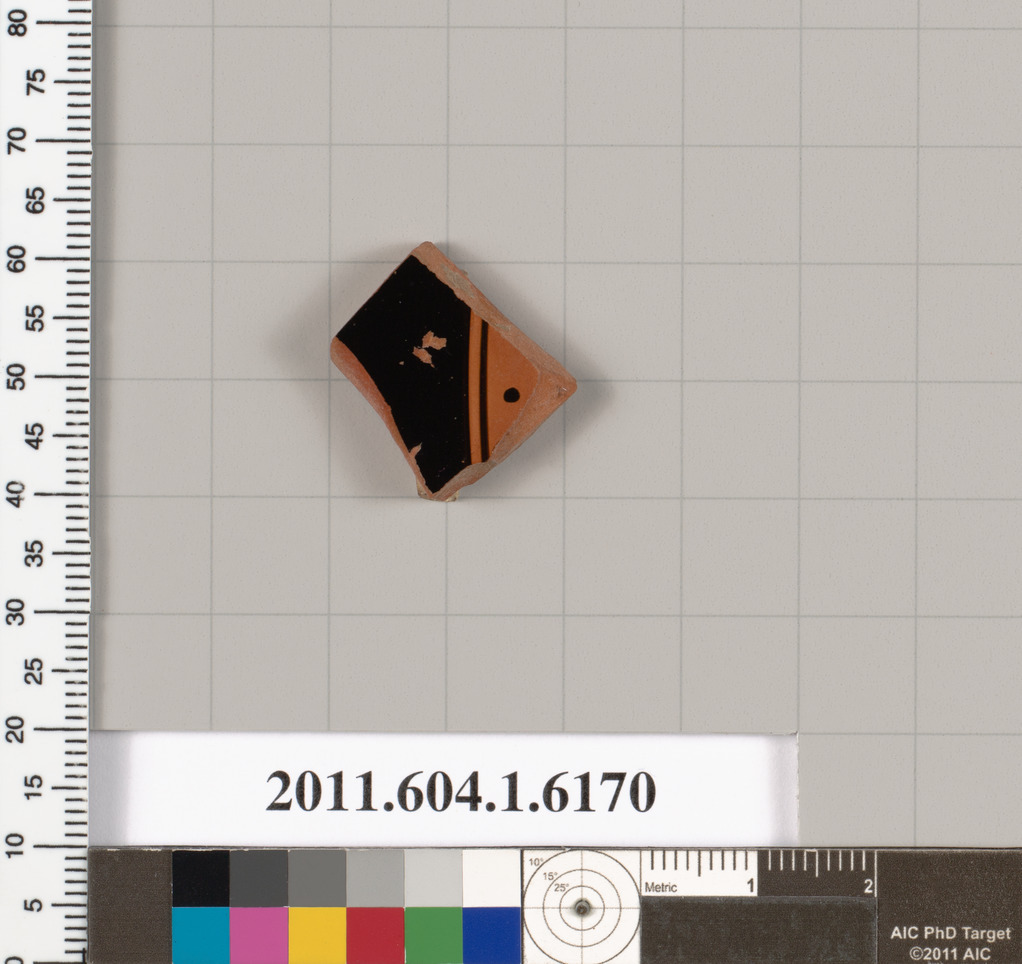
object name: kylix fragment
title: Terracotta fragment of a kylix (drinking cup)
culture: greek, attic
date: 520-500 BCE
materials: terracotta